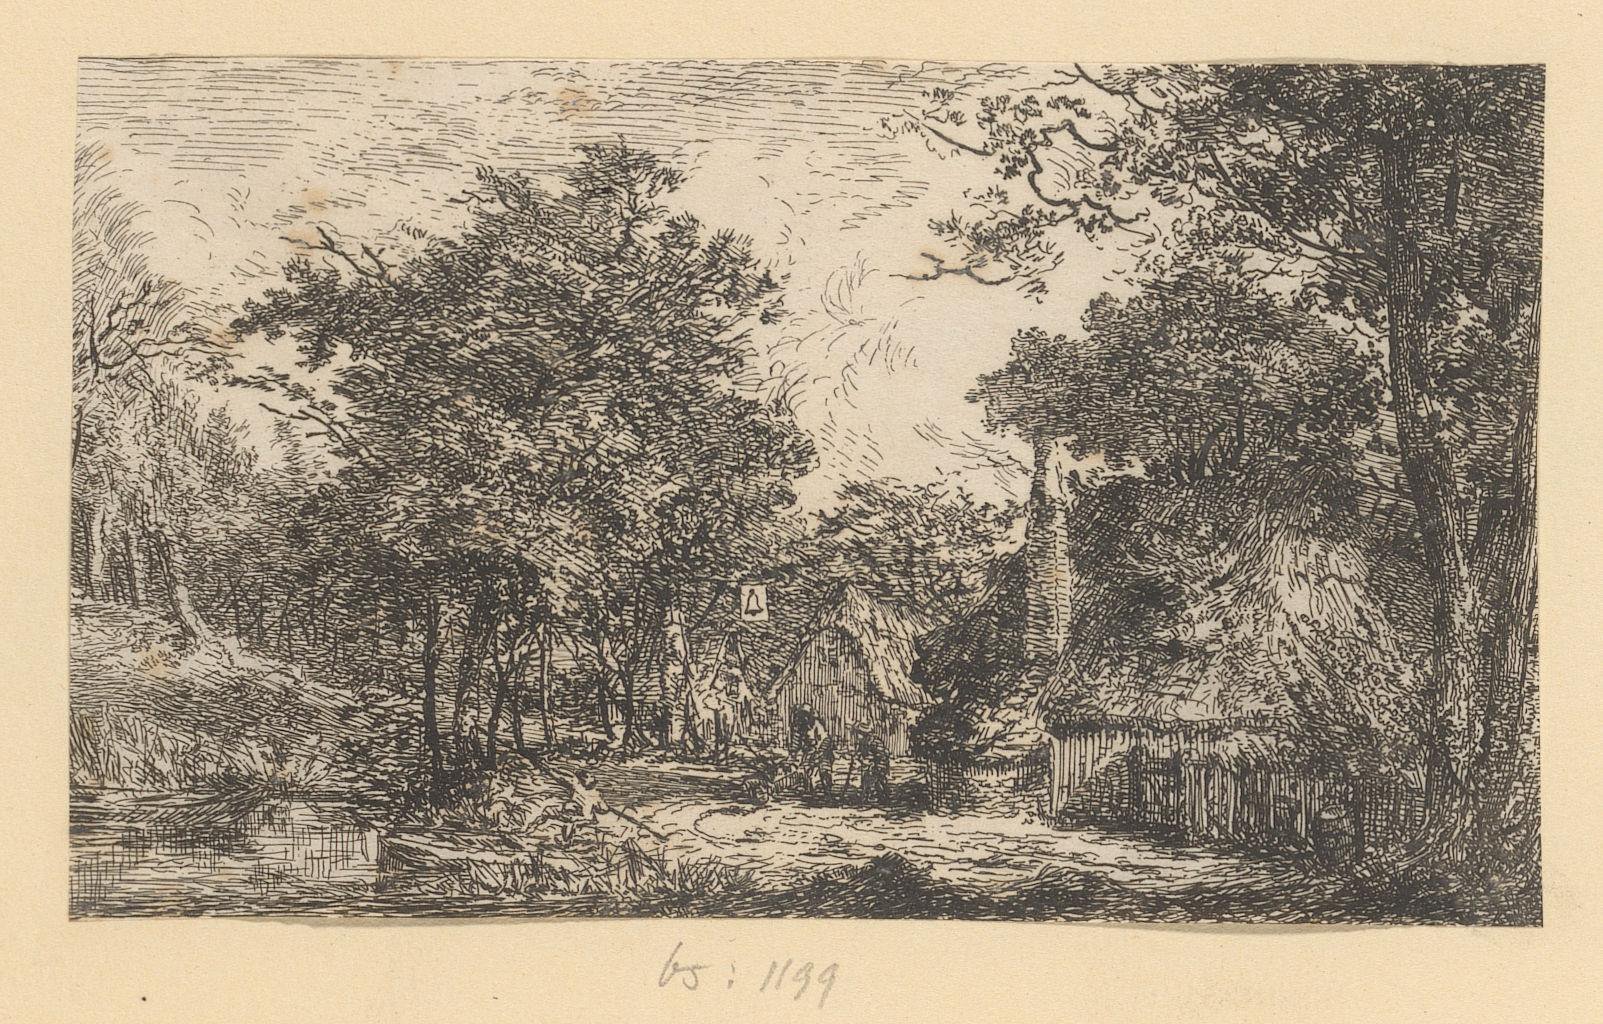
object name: print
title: Twenty rural landscapes from nature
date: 1793-1795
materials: paper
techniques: etching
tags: landscapes (+ landscape with figures, staffage), farm (building)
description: Deze prent hoort bij een serie van 20 prenten. Prent maakt mogelijk deel uit van een serie van 200 prenten. Deze serie is onder de titel 'A Collection of two hundred original etchings' voor het eerst uitgegeven door J.M. Greery in 1816.